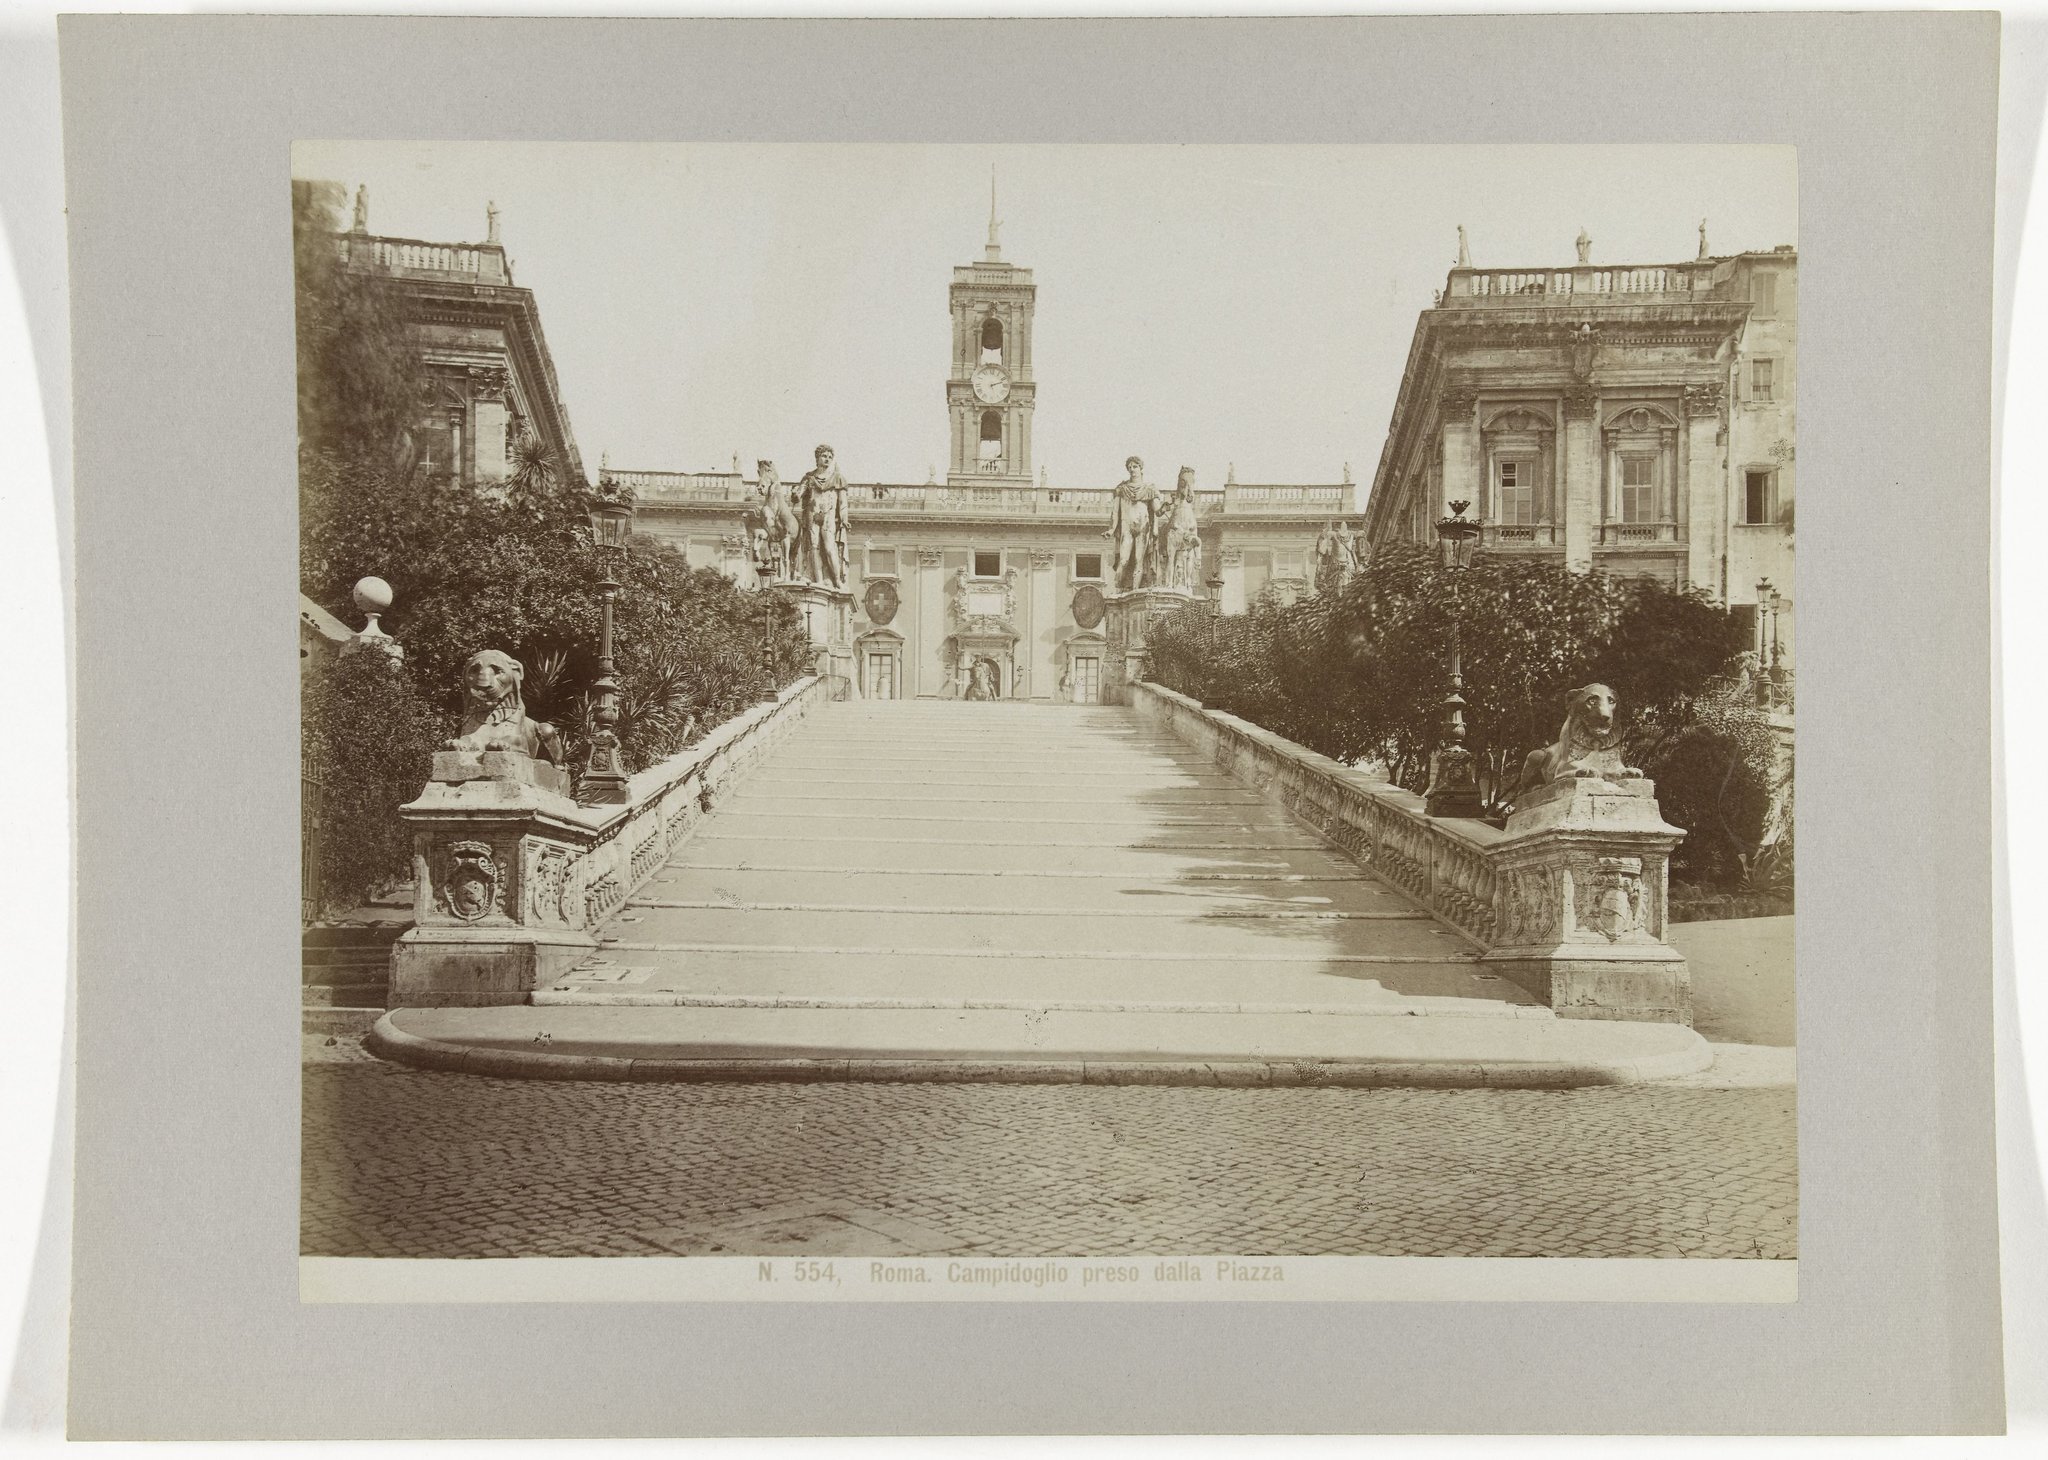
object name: photograph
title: Capitolijn nabij de Piazza del Campidoglio, Rome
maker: Anonymous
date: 1880-1904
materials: cardboard, paper, photographic support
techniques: albumen print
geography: rome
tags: capitool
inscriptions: number: ‘11.’